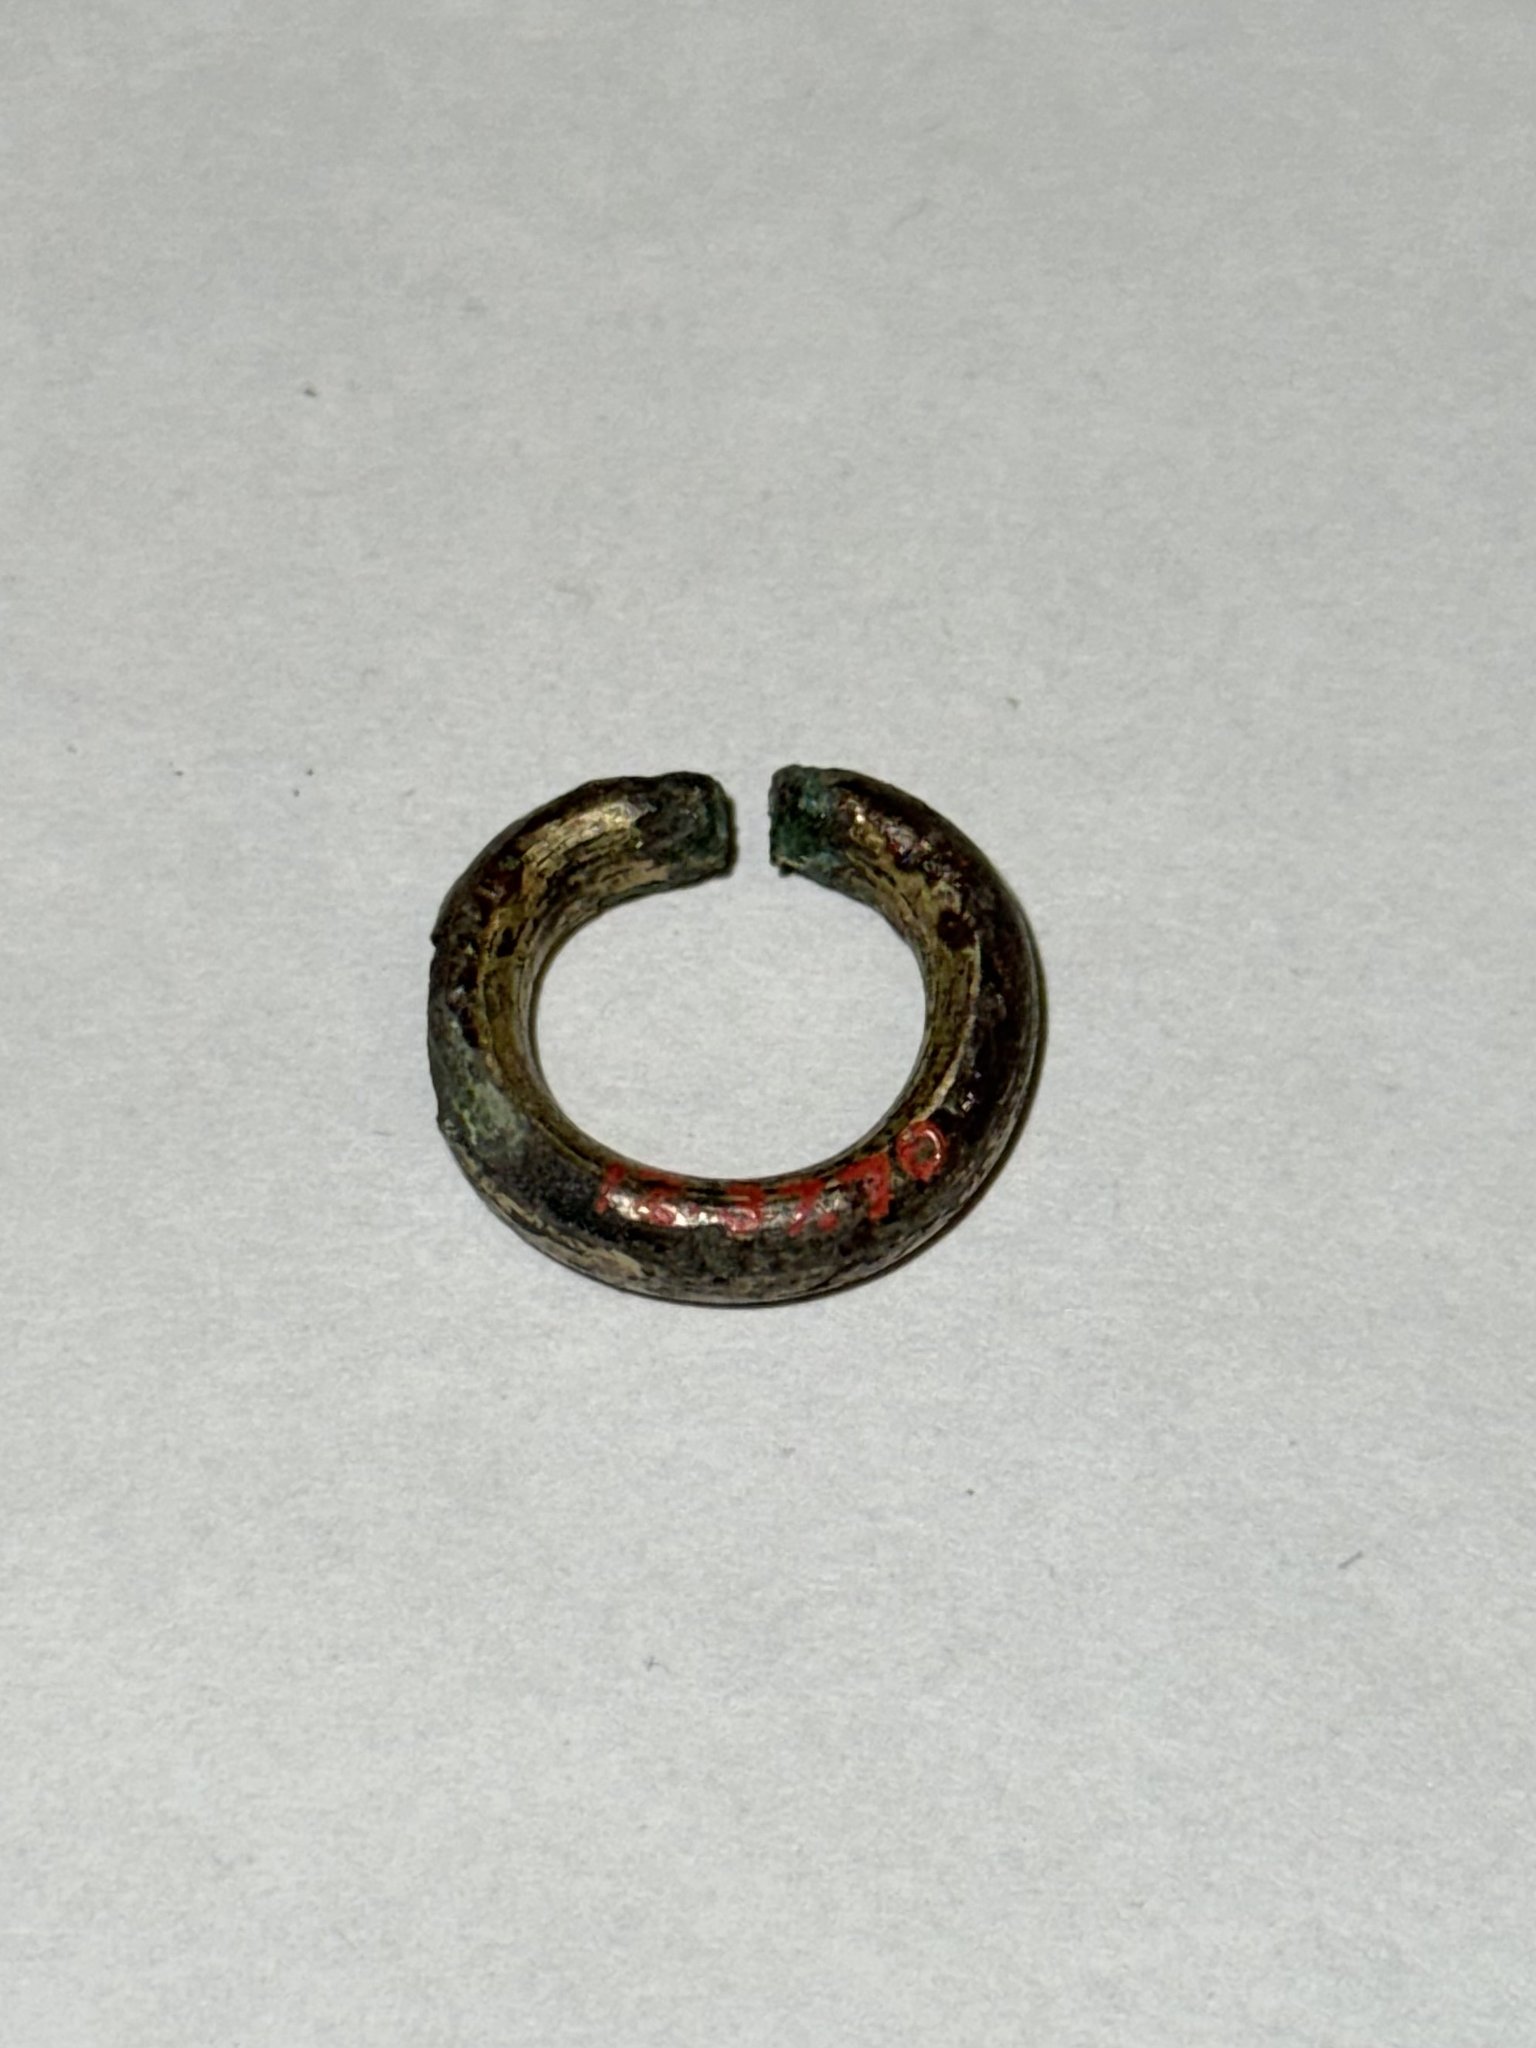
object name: earring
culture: japanese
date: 601-700